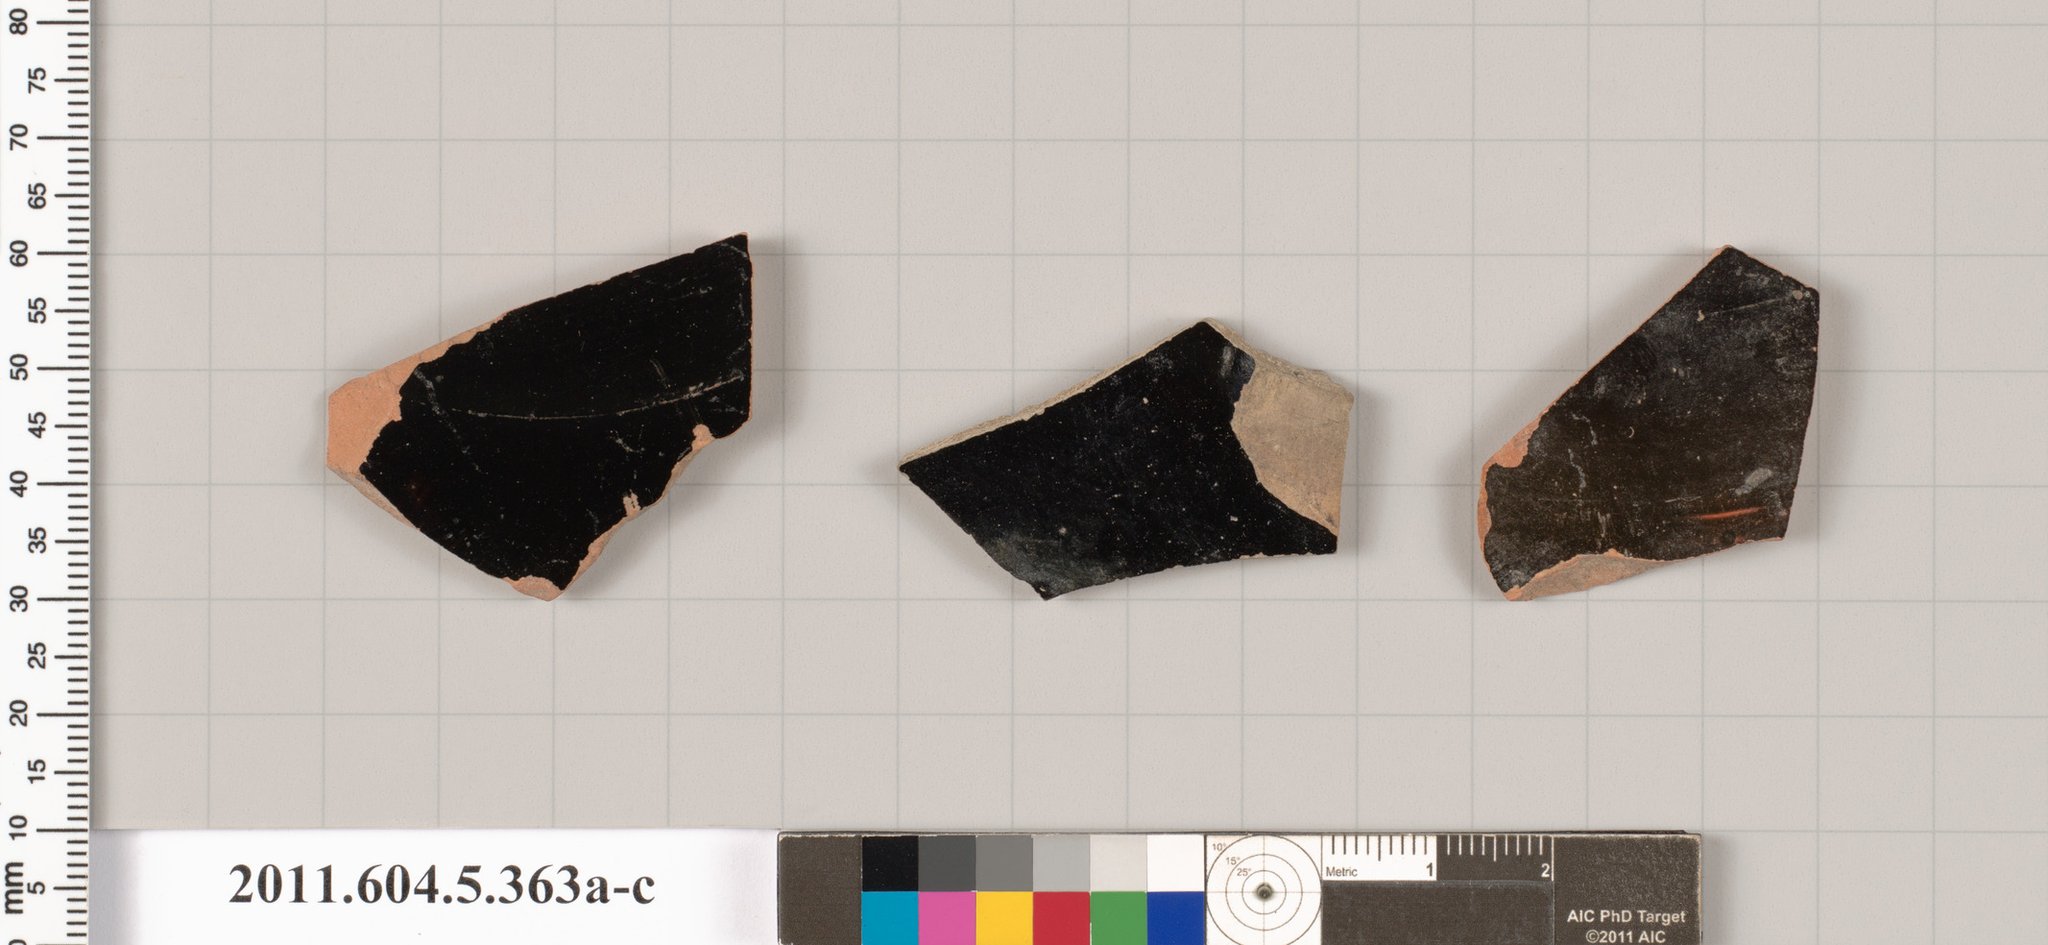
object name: kylix fragment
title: Terracotta fragments of kylikes (drinking cups)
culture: greek, attic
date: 600-401 BCE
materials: terracotta